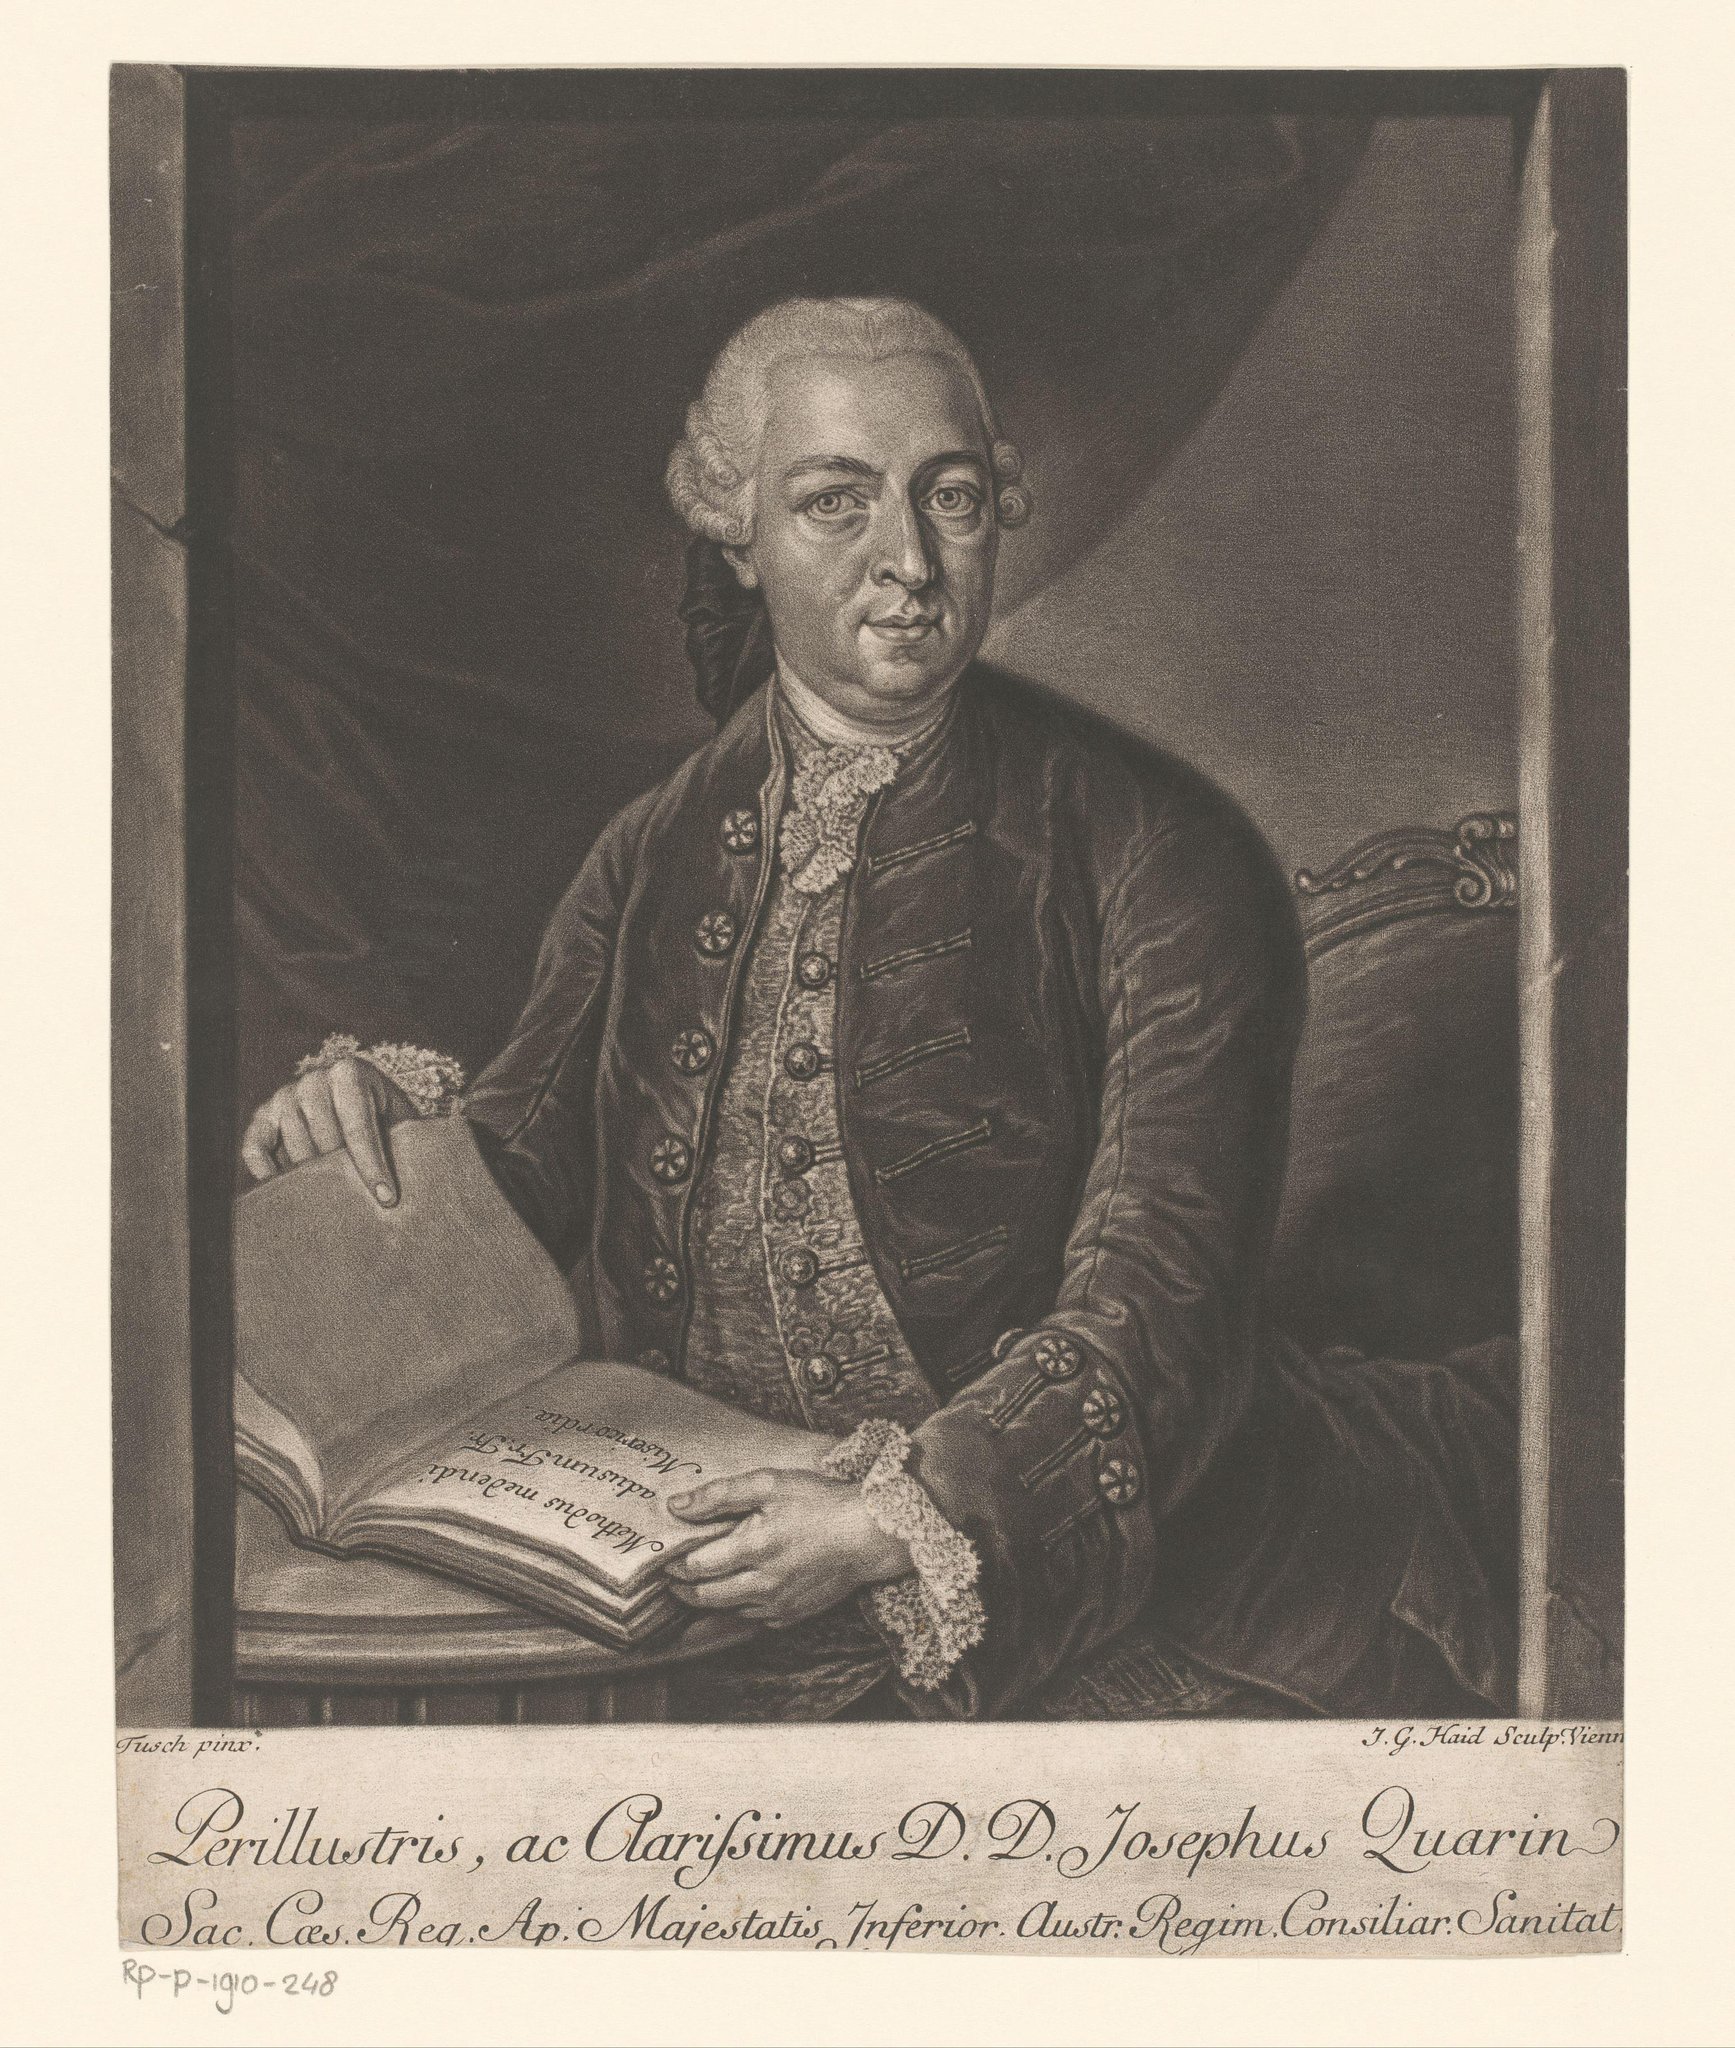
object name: print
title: Portret van Joseph Freiherr von Quarin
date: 1748-1776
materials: paper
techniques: mezzotint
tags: joseph freiherr von quarin, historical persons, physician, doctor, book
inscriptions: collector's mark: Lugt 2228